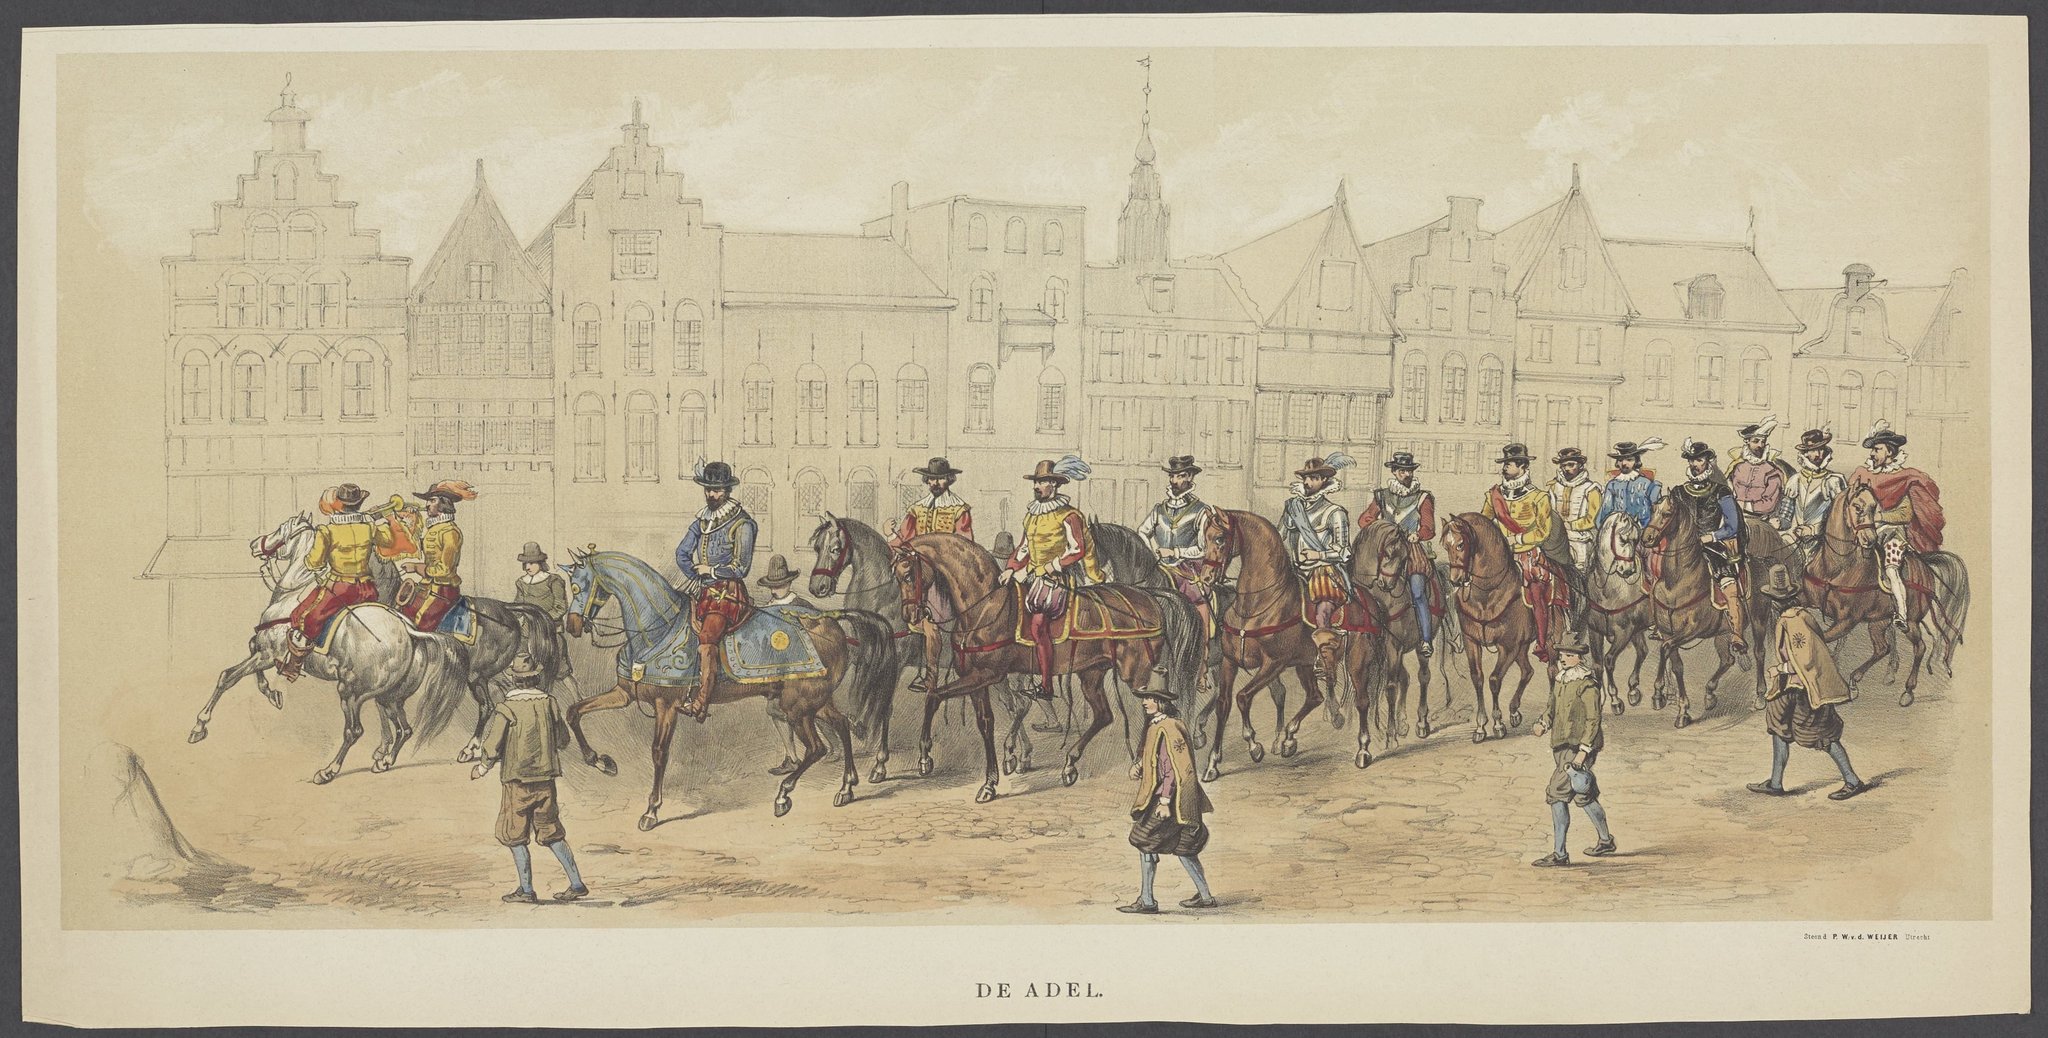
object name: print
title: De Grondleggers van Neêrlands Vrijheid, (tijd van Willem I) voorgesteld door H.H. leden van het Utrechtsche studenten-corps, ter viering van het 220jarig bestaan der Utrechtsche Hoogeschool, den 17 Junij 1856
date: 1856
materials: paper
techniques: hand coloring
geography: netherlands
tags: delft, william i (prince of orange), students' pageant, costumes used in pageants, utrecht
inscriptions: collector's mark: Lugt 2228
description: De adel: ruiteroptocht. Onderdeel van een groep van vijf platen met verklaring van de historische optocht in maskerade opgevoerd door de studenten van de Utrechtse Hogeschool op 17 juni 1856 ter gelegenheid van de viering van haar 220-jarige bestaan.